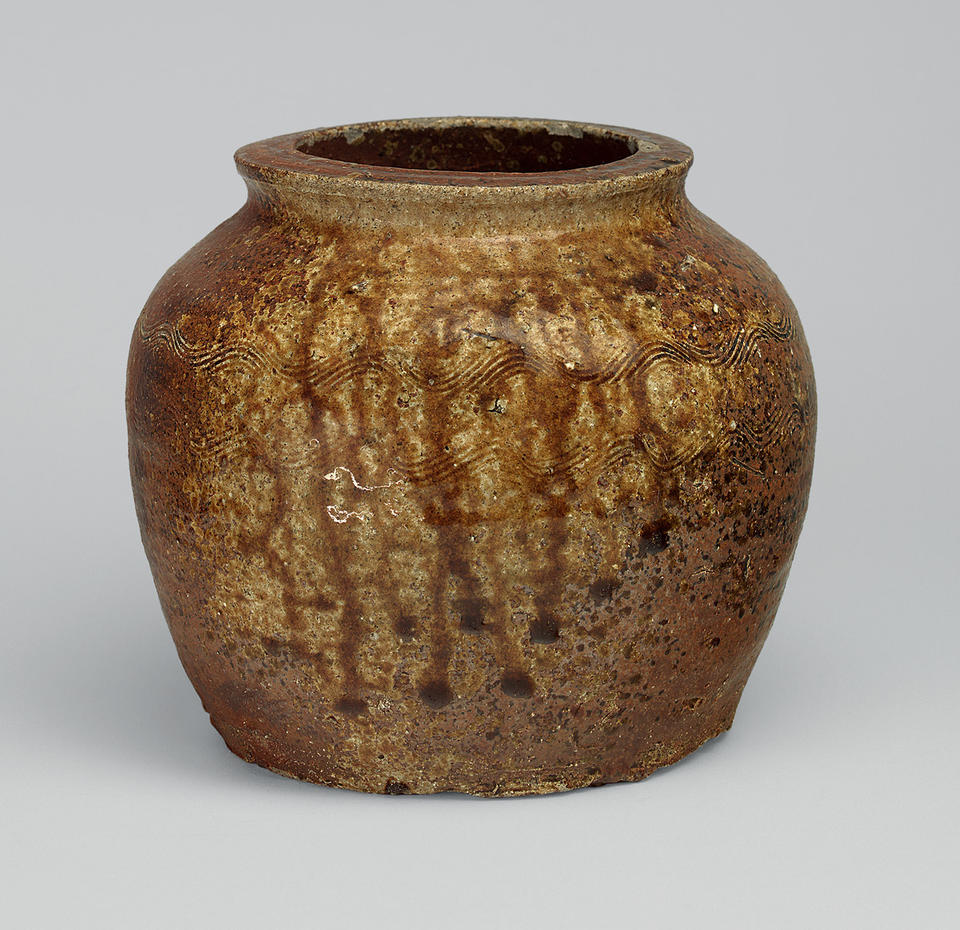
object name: jar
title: Widemouthed Oil Jar (Kame) with Wave Pattern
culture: japanese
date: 1701-1800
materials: wood, glaze, stoneware